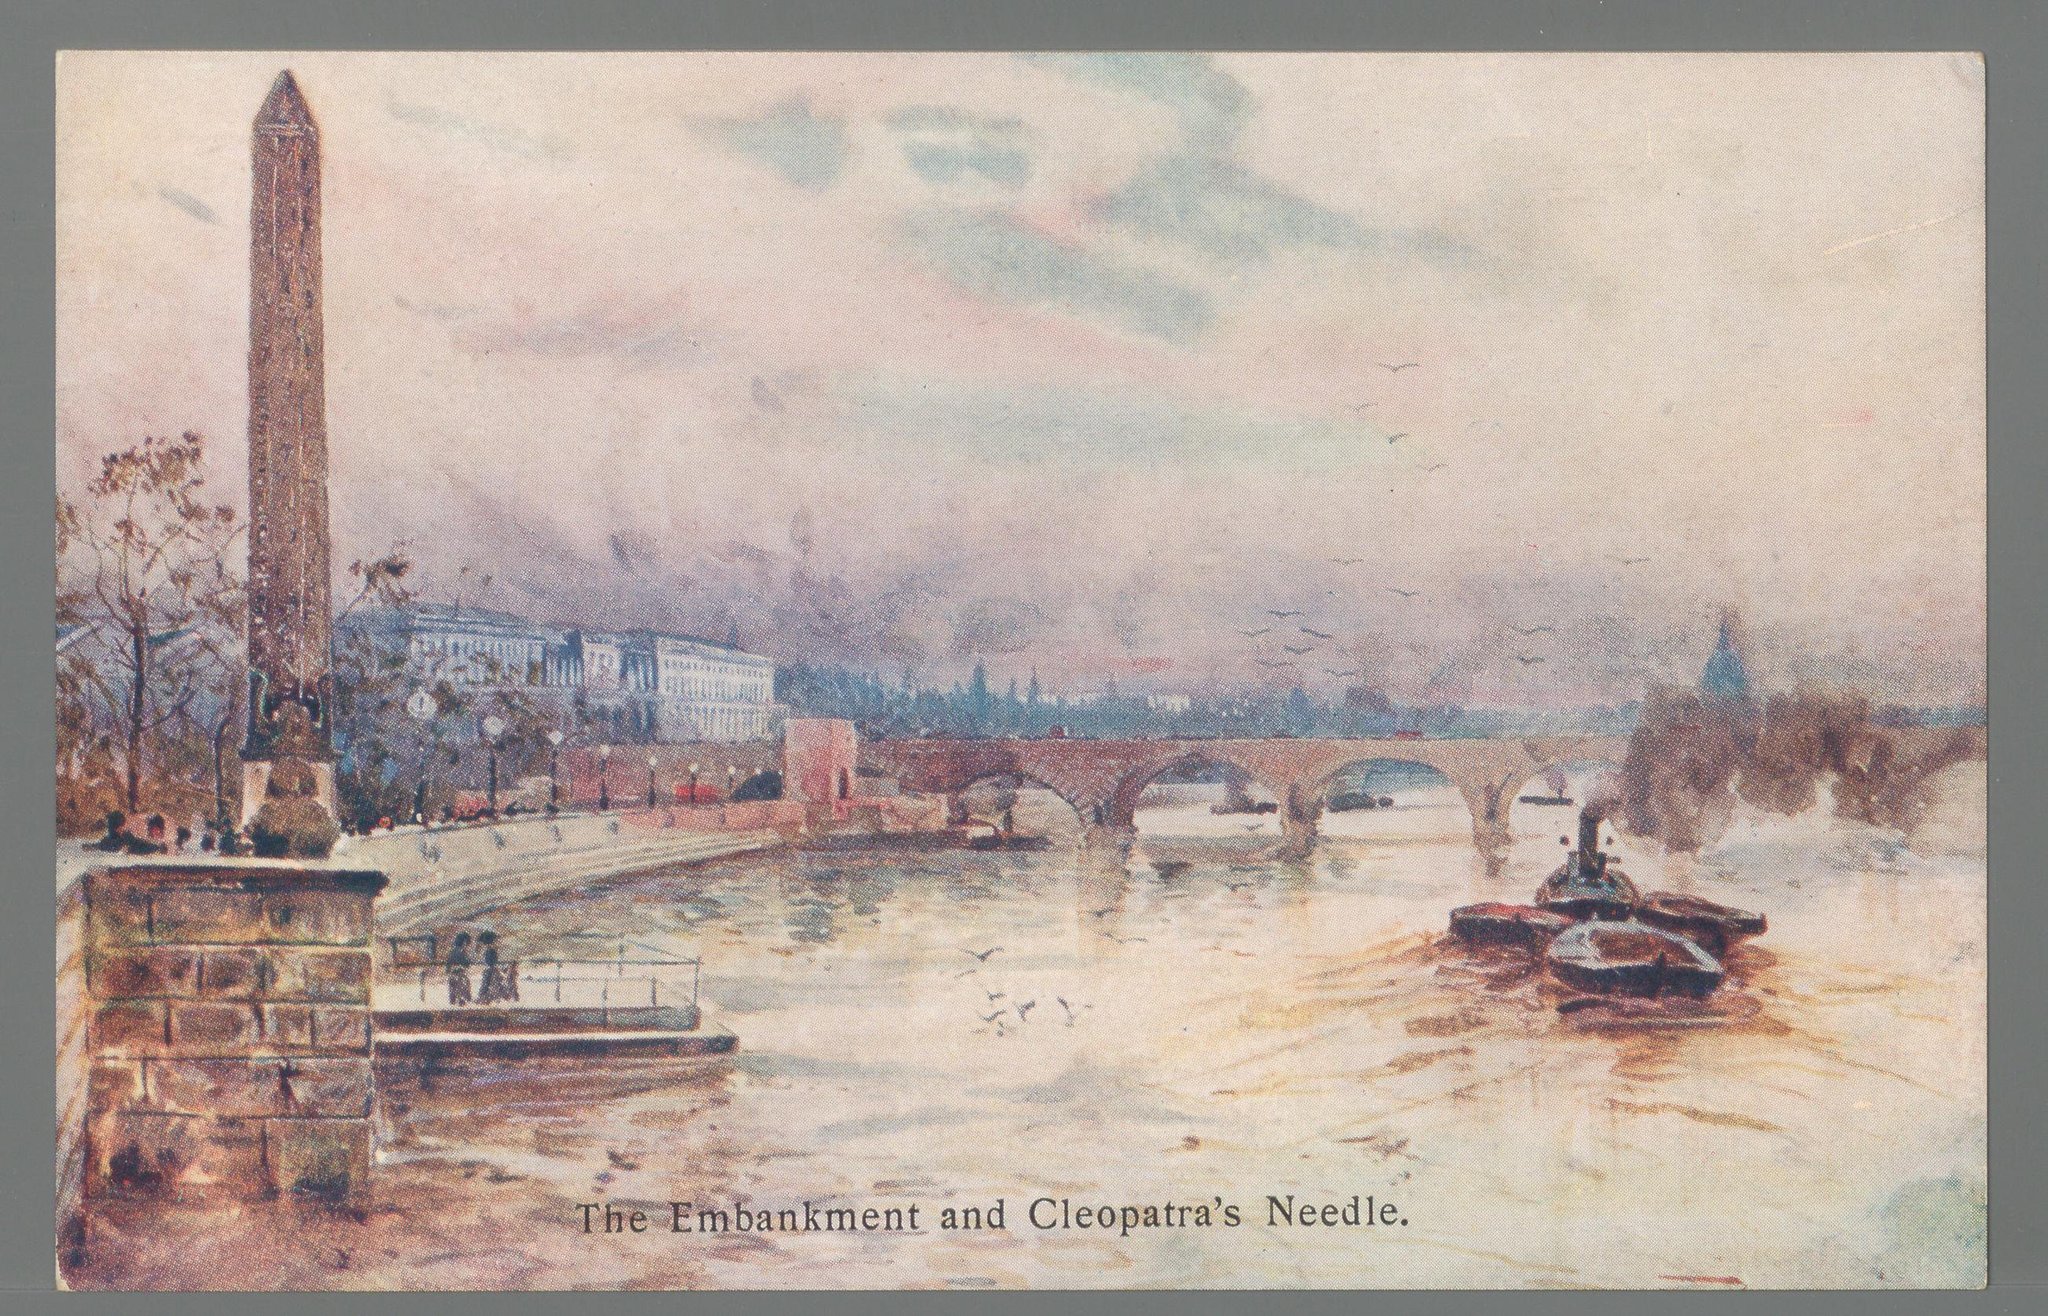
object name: ansichtkaart, prentbriefkaart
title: The Embankment and Cleopatra's Needle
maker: Anonymous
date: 1902-1940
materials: cardboard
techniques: color autotype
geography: london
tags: obelisk, needle, canals, waters (in city), bridge in city across river, canal, etc., quay, thames